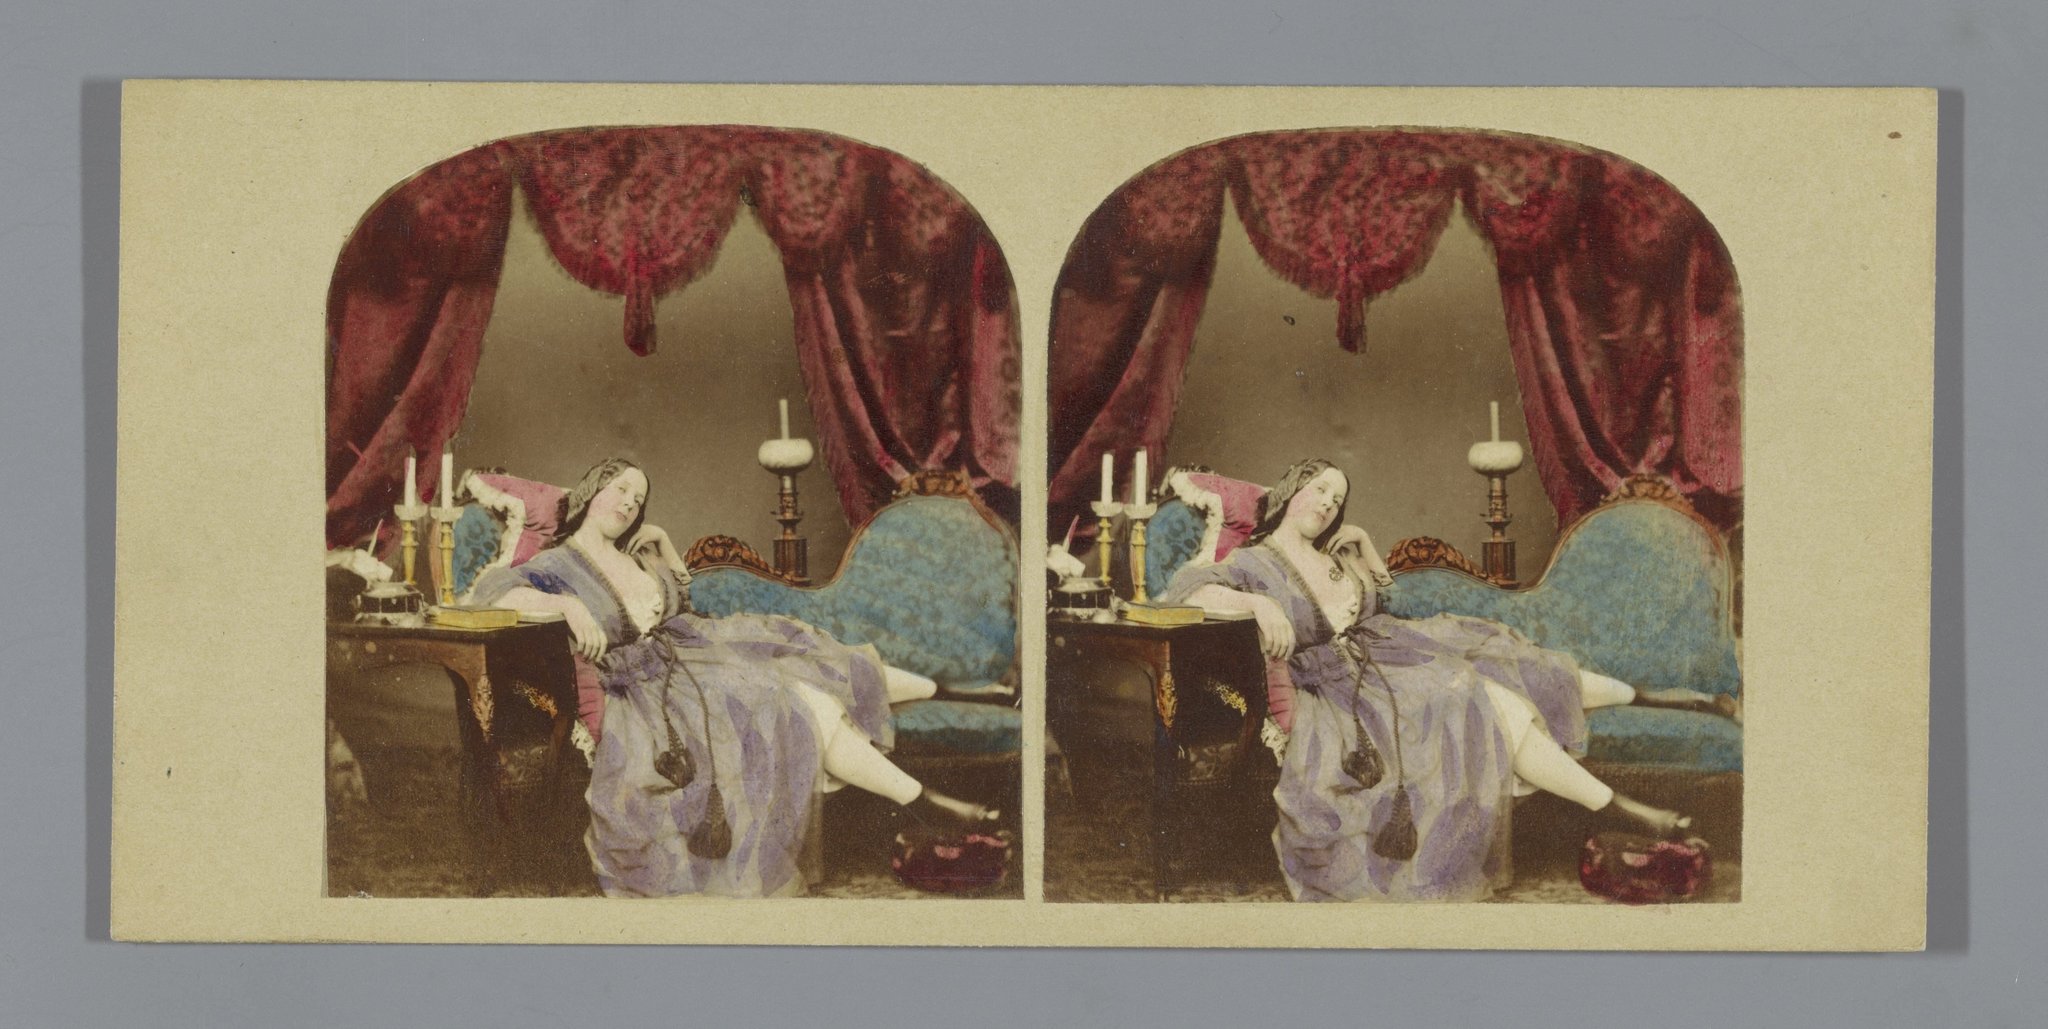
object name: stereograph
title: Vrouw op een sofa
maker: Anonymous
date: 1852-1858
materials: cardboard, paper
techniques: albumen print, hand coloring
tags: adult woman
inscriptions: number: ‘2002/ 107’